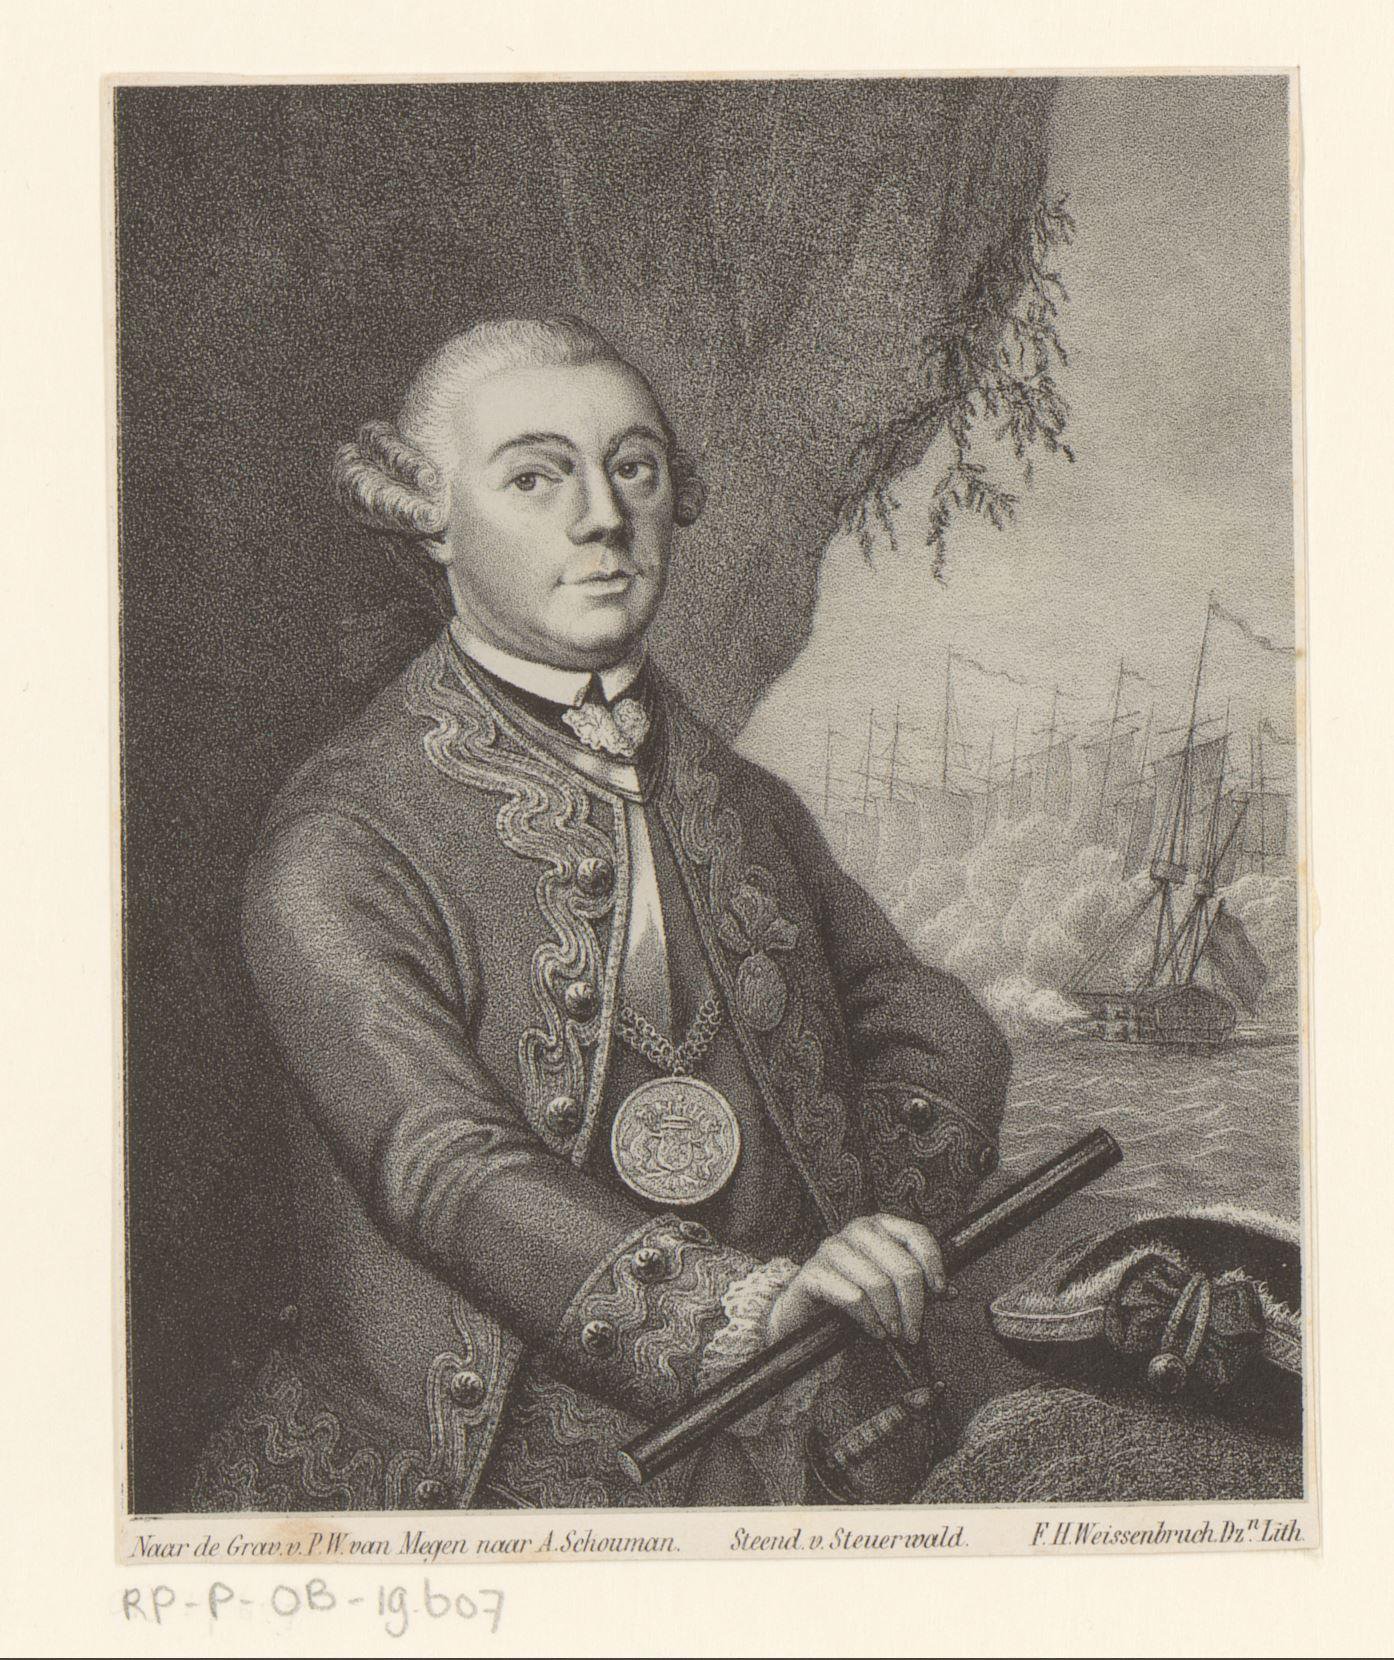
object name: book illustration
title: Portret van Johan Arnold Zoutman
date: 1858-1862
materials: paper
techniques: lithograph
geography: the hague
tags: johan arnold zoutman, historical persons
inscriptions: collector's mark: Lugt 2228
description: Prent uit: Jonge, J.C. de. Geschiedenis van het Nederlandsche zeewezen. Haarlem: Jonge, J.K.J. de, 1858-62.